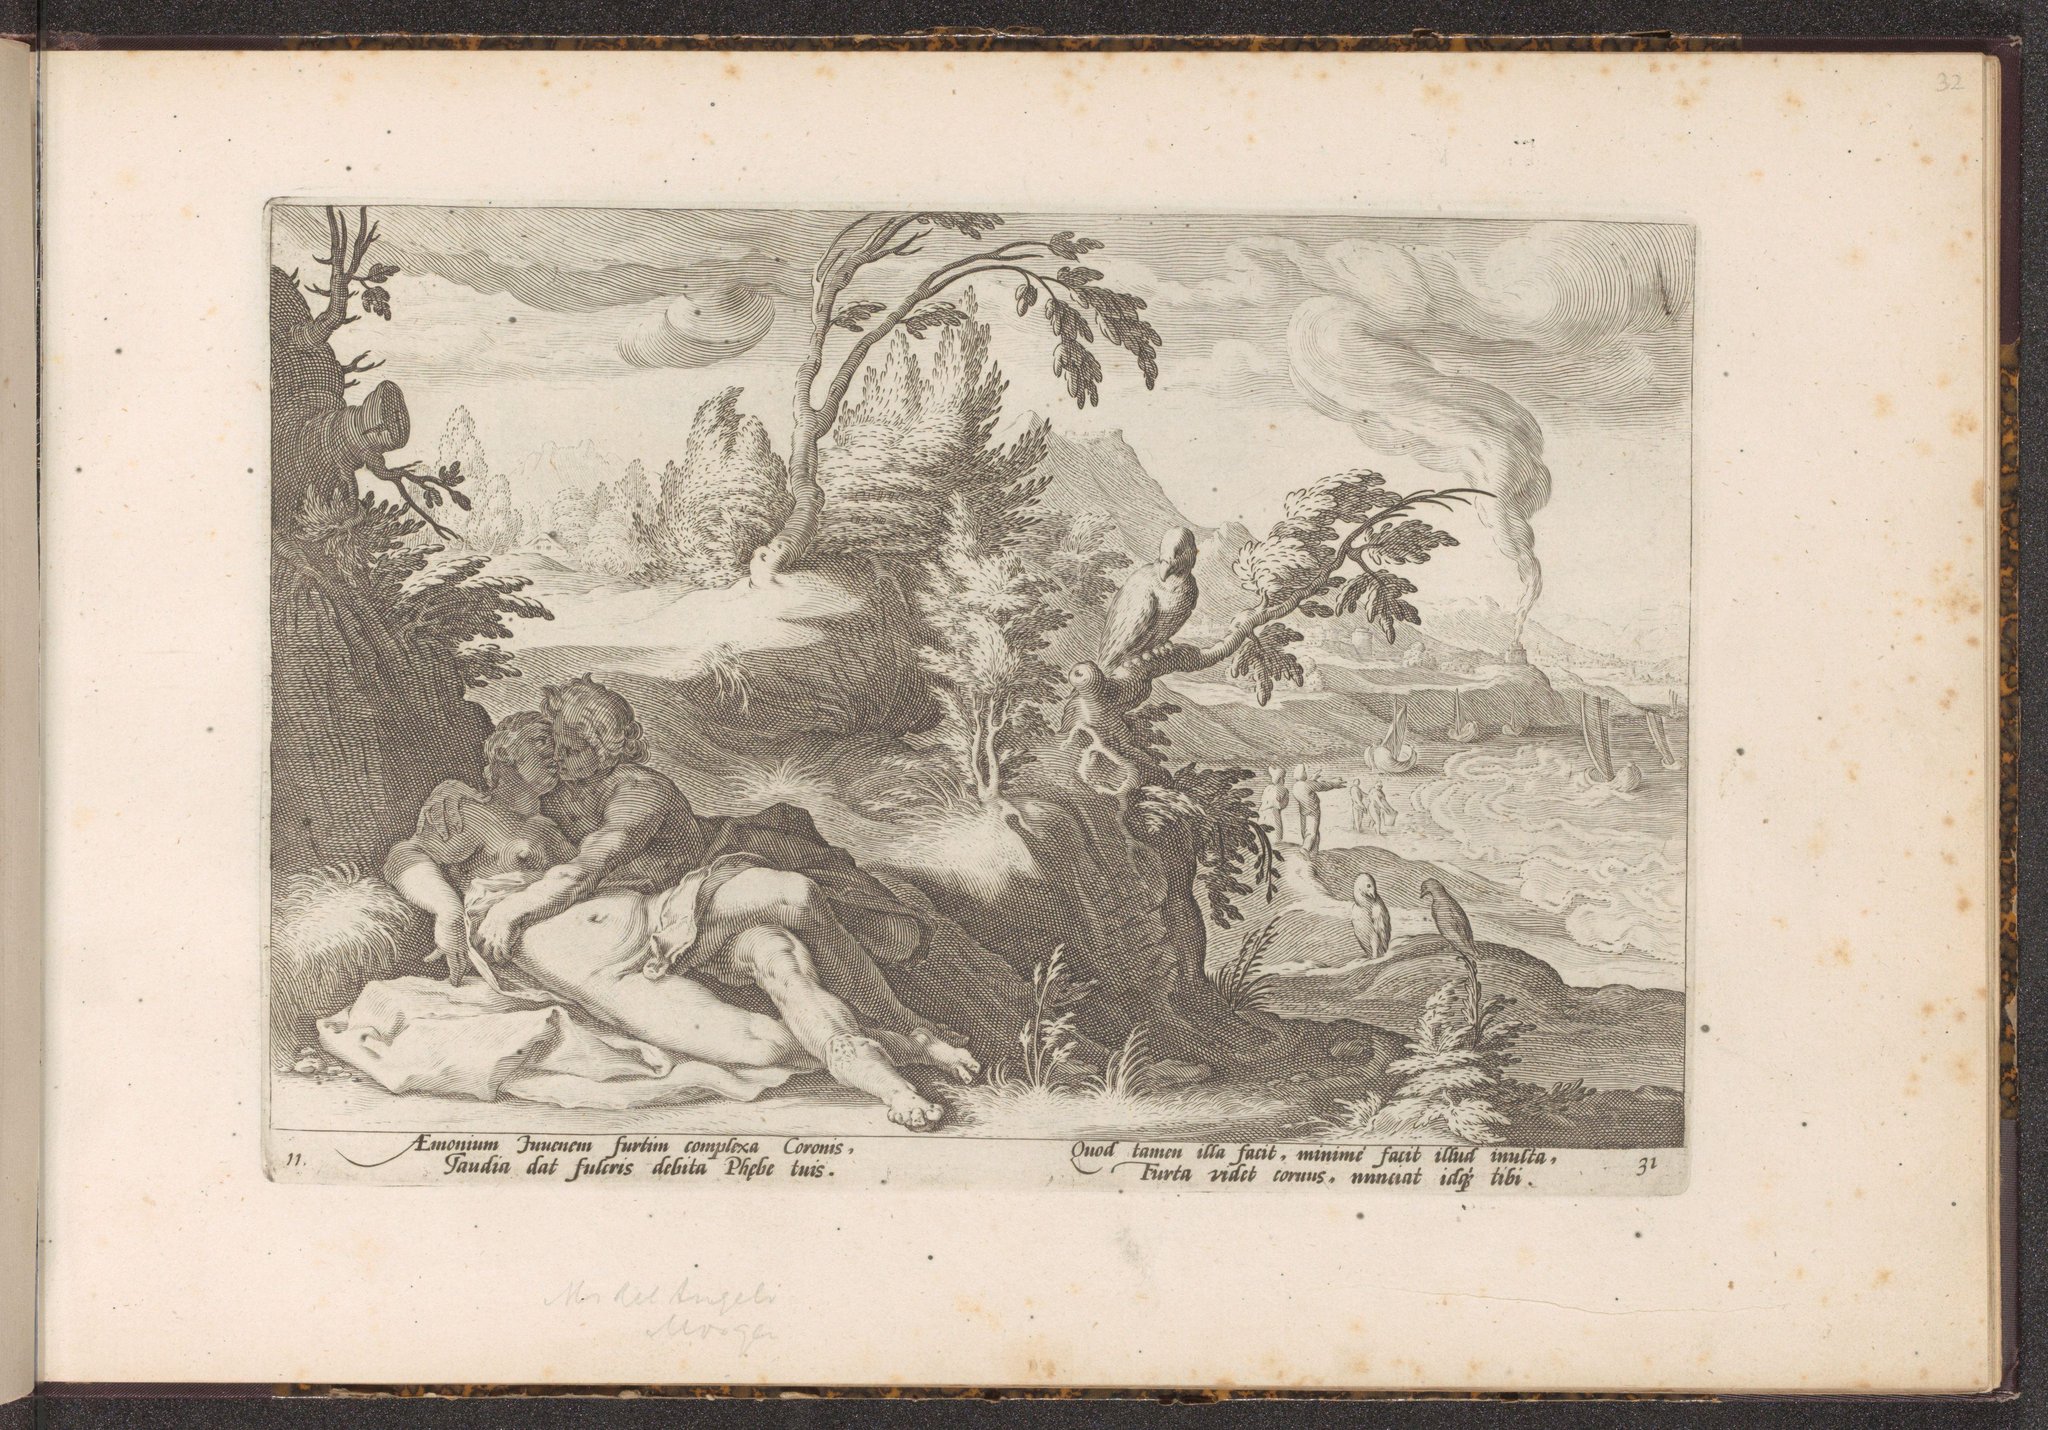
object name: album leaf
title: Herscheppingen van P. Ovidius Naso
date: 1590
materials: paper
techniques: engraving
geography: haarlem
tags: a white crow sees coronis' infidelity and tells apollo about it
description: De witte raaf Corvus betraft Coronis, geliefde van Apollo, op ontrouw. Als hij dit aan de god wil melden, wordt hij voor zijn plan gewaarschuwd door de kraai Cornix. Op de achtergrond rechts een kustlandschap. Onder de voorstelling twee keer twee versregels in het Latijn. De prent maakt deel uit van een album.